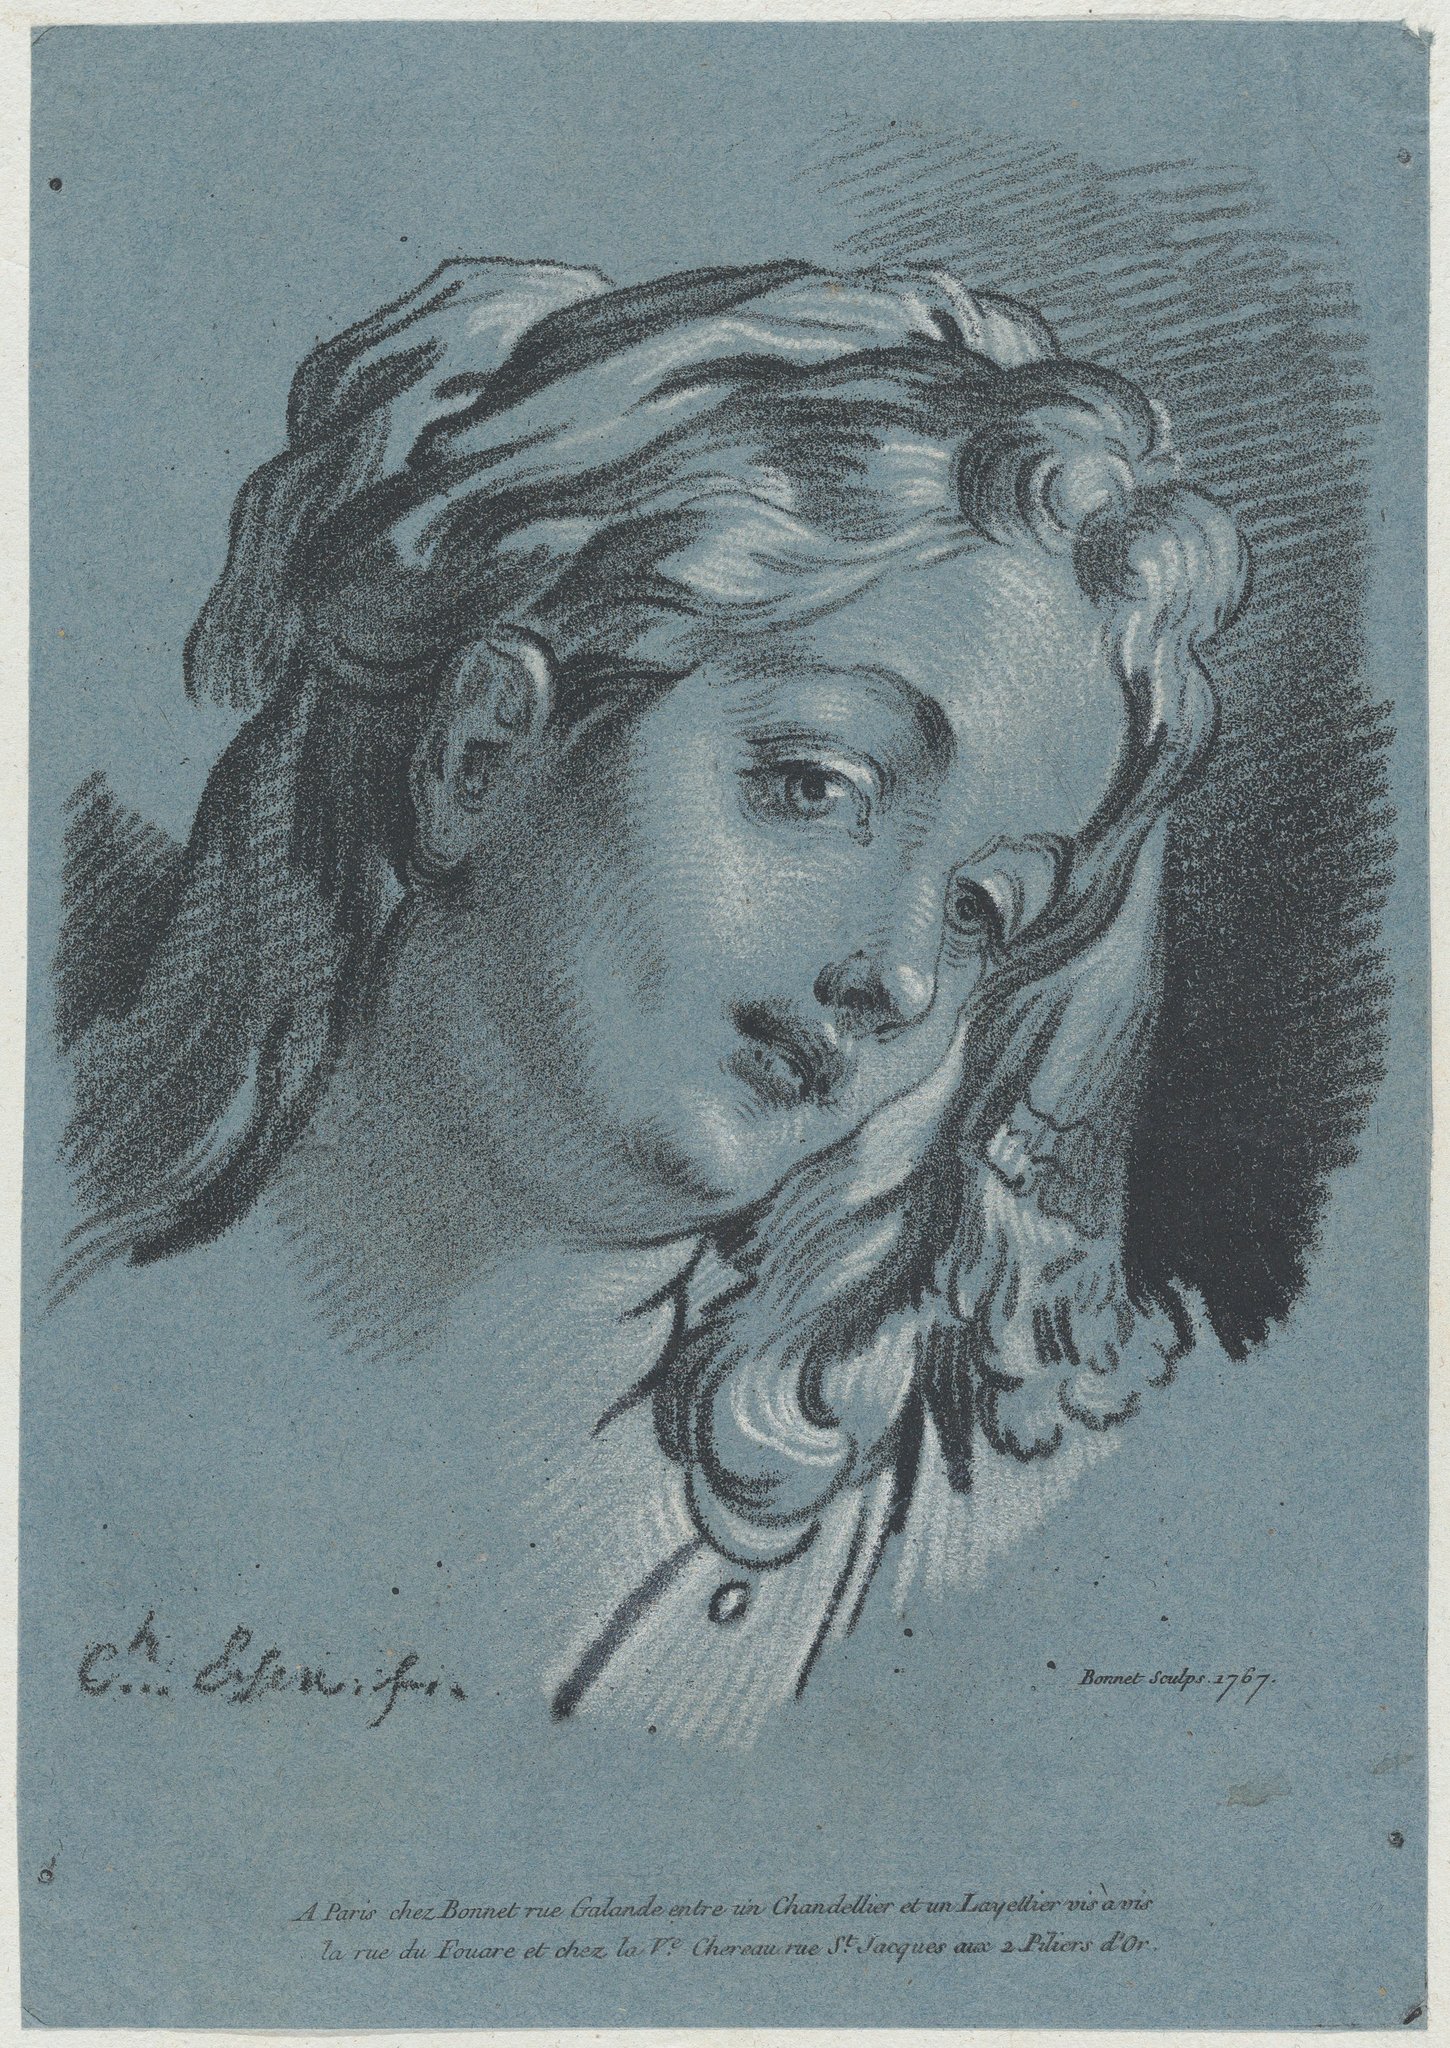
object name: print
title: Head of a Woman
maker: louis marin bonnet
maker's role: artist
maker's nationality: french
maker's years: 1736-1793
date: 1767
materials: chalk, paper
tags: heads,portraits,women